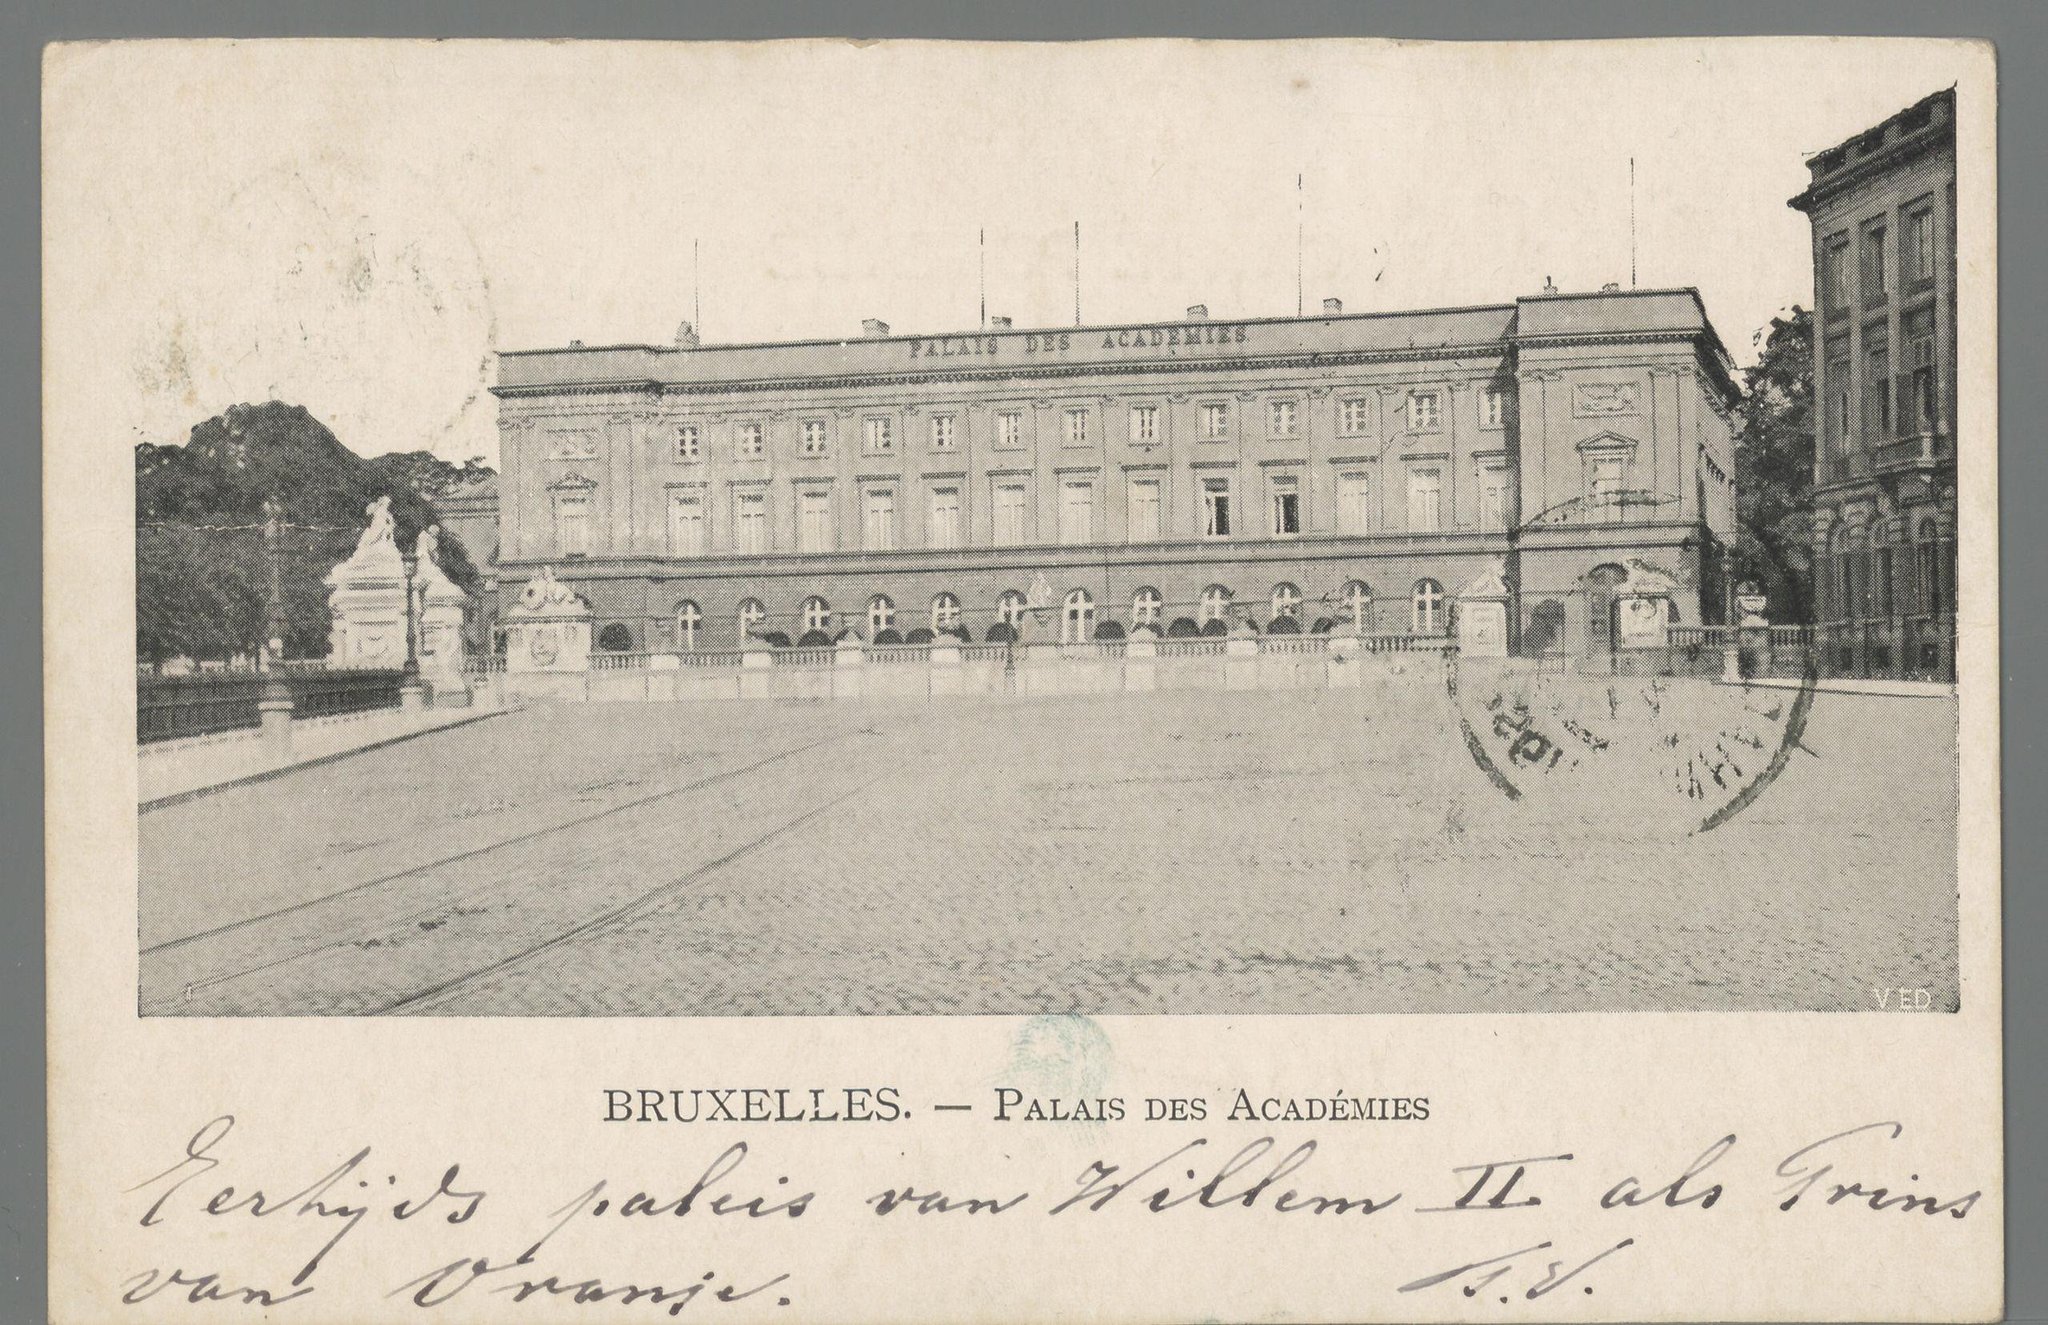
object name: ansichtkaart, prentbriefkaart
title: Bruxelles. Palais des académies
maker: Anonymous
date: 1892-1902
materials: cardboard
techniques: writing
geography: brussels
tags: square, place, circus, etc., palace, brussels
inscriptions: poststempel, verso, gestempeld, poststempel, recto, gestempeld